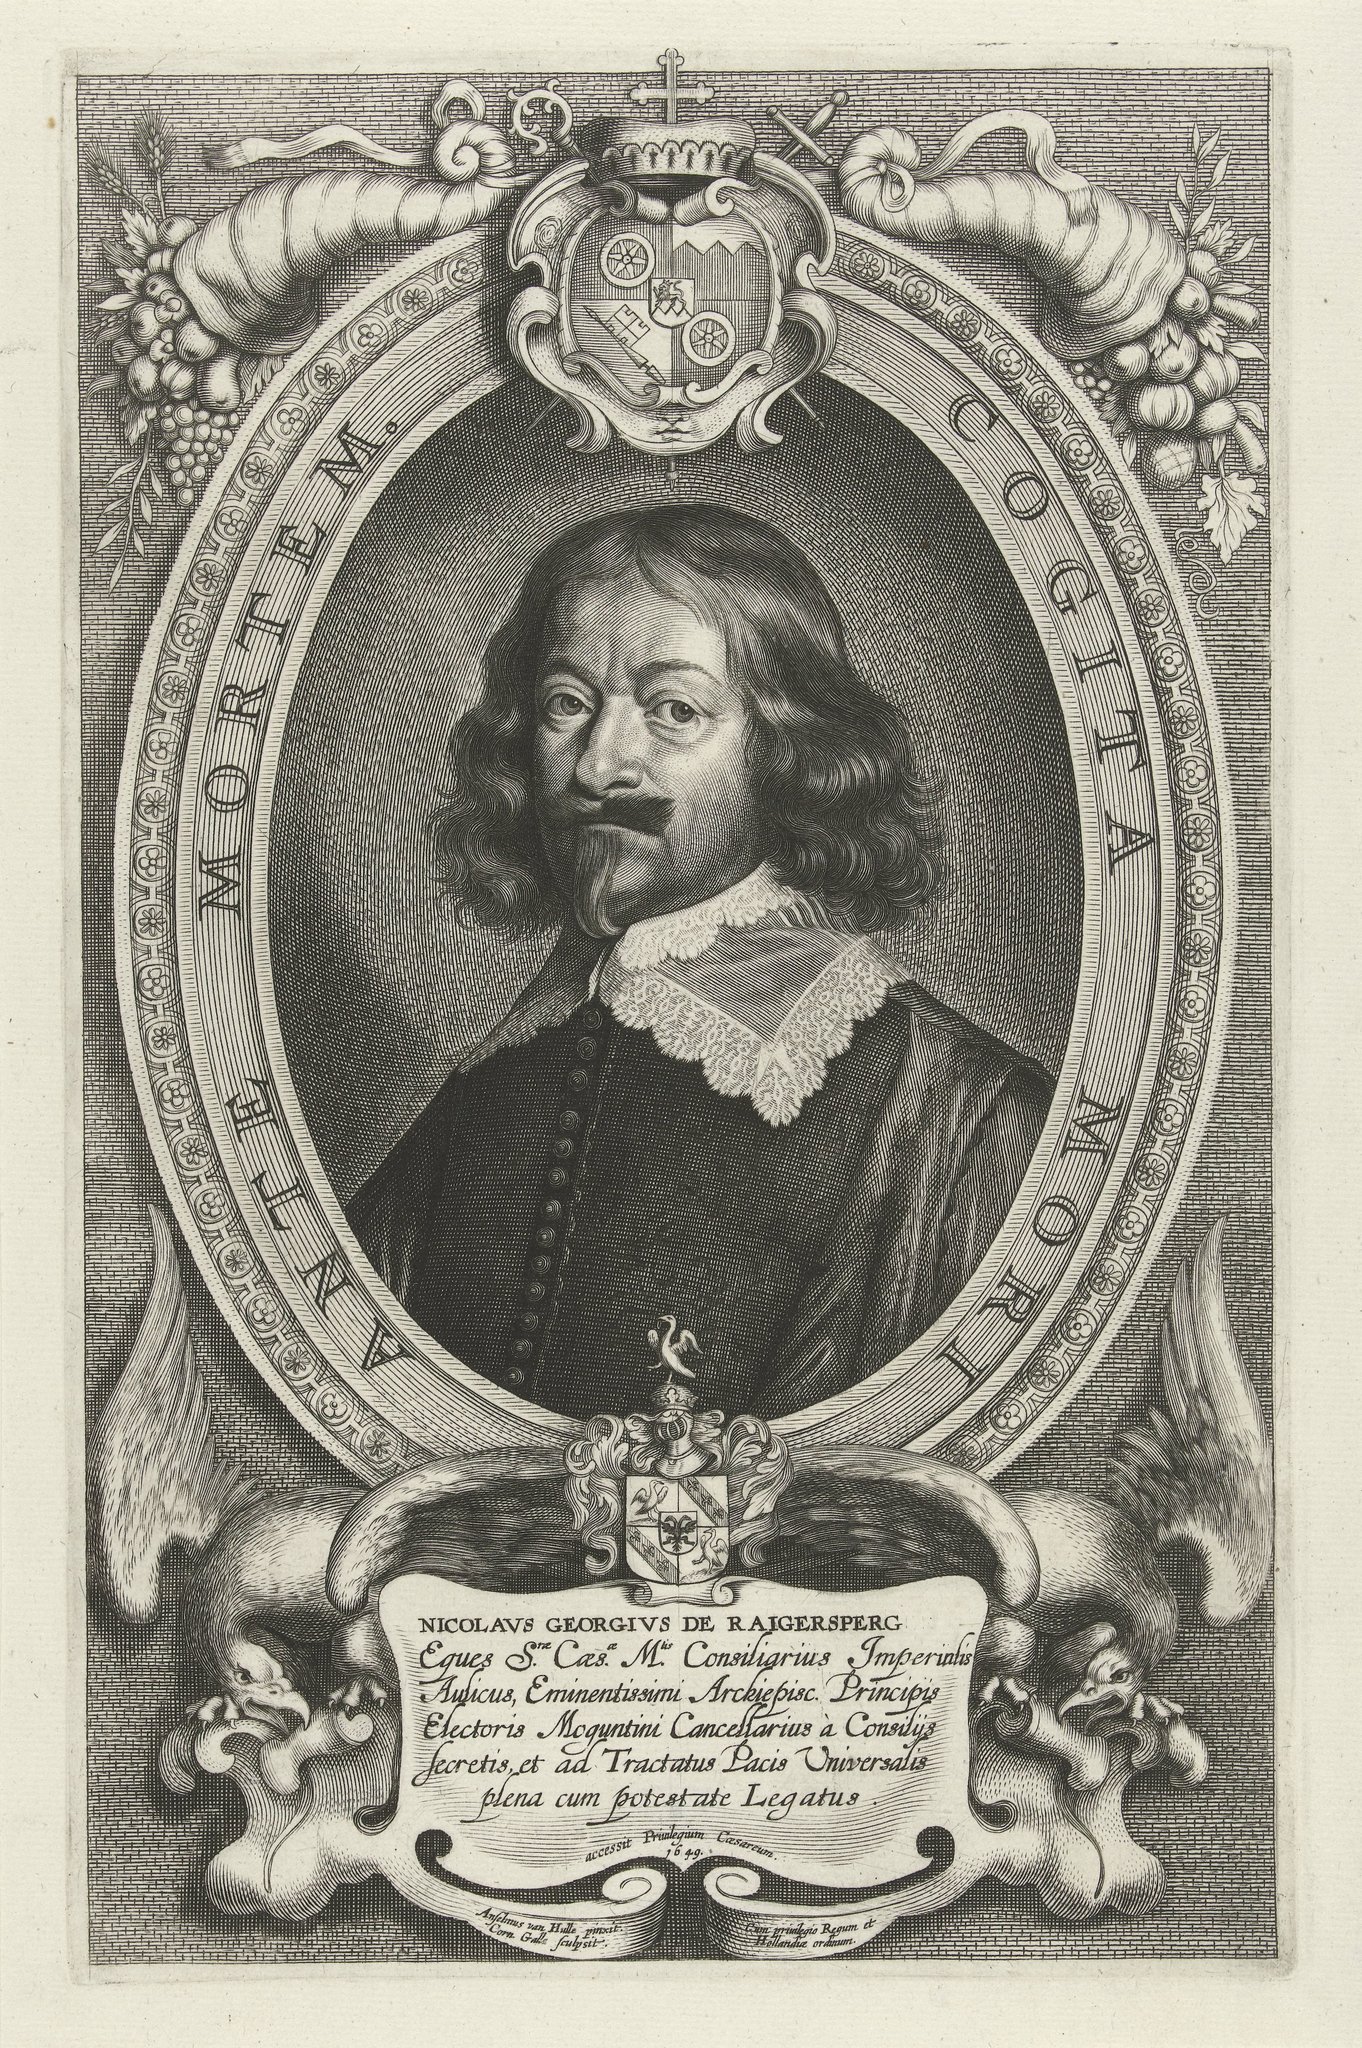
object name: print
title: Celeberrimi ad pacificandum Christiani nominis orbem legati Monasterium et Osnabrugas (...)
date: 1649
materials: paper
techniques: engraving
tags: aschaffenburg, afgezant, nikolaus georg reigersberg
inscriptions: collector's mark: Lugt 2228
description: Portret van Nicolaus Georg von Reigersberg, afgezant van Keur-Mainz tijdens de onderhandelingen voor de Vrede van Münster. Portret in ovaal met randschrift. Boven het wapen van Keur-Mainz, onder Reigersbergs familiewapen.